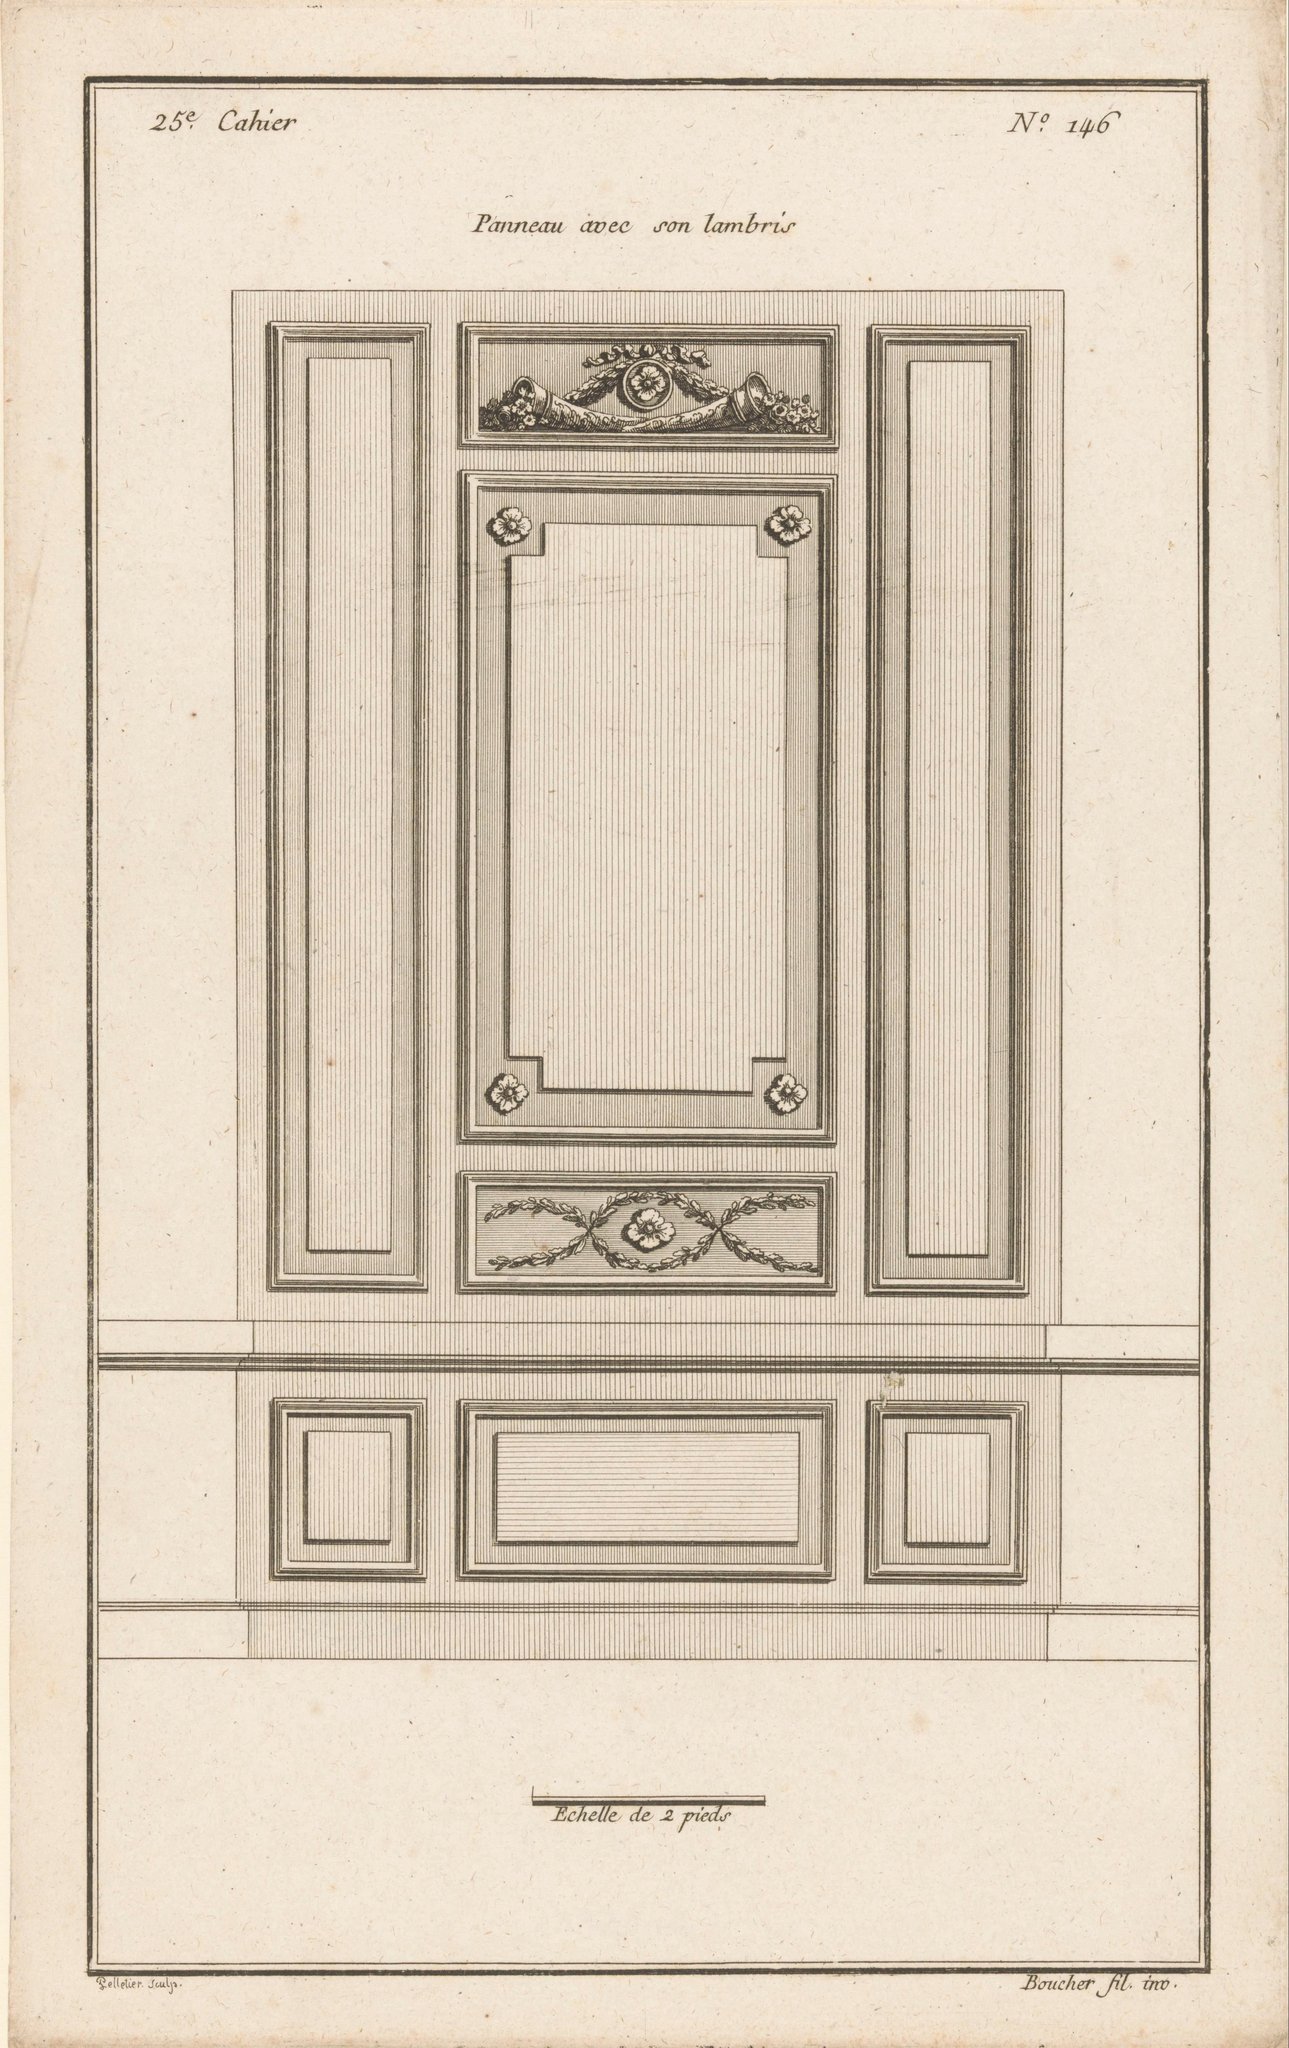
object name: ornament print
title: 25e Cahier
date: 1772-1779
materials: paper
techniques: engraving, etching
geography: paris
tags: 'cornucopia', horn of plenty, panelling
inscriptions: collector's mark: Lugt 2228, collector's mark: Lugt 2760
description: Een wand met panelen, gedecoreerd met ranken, bloemmotieven en aan de bovenzijde twee hoornen des overvloeds. Prentnummer 146.